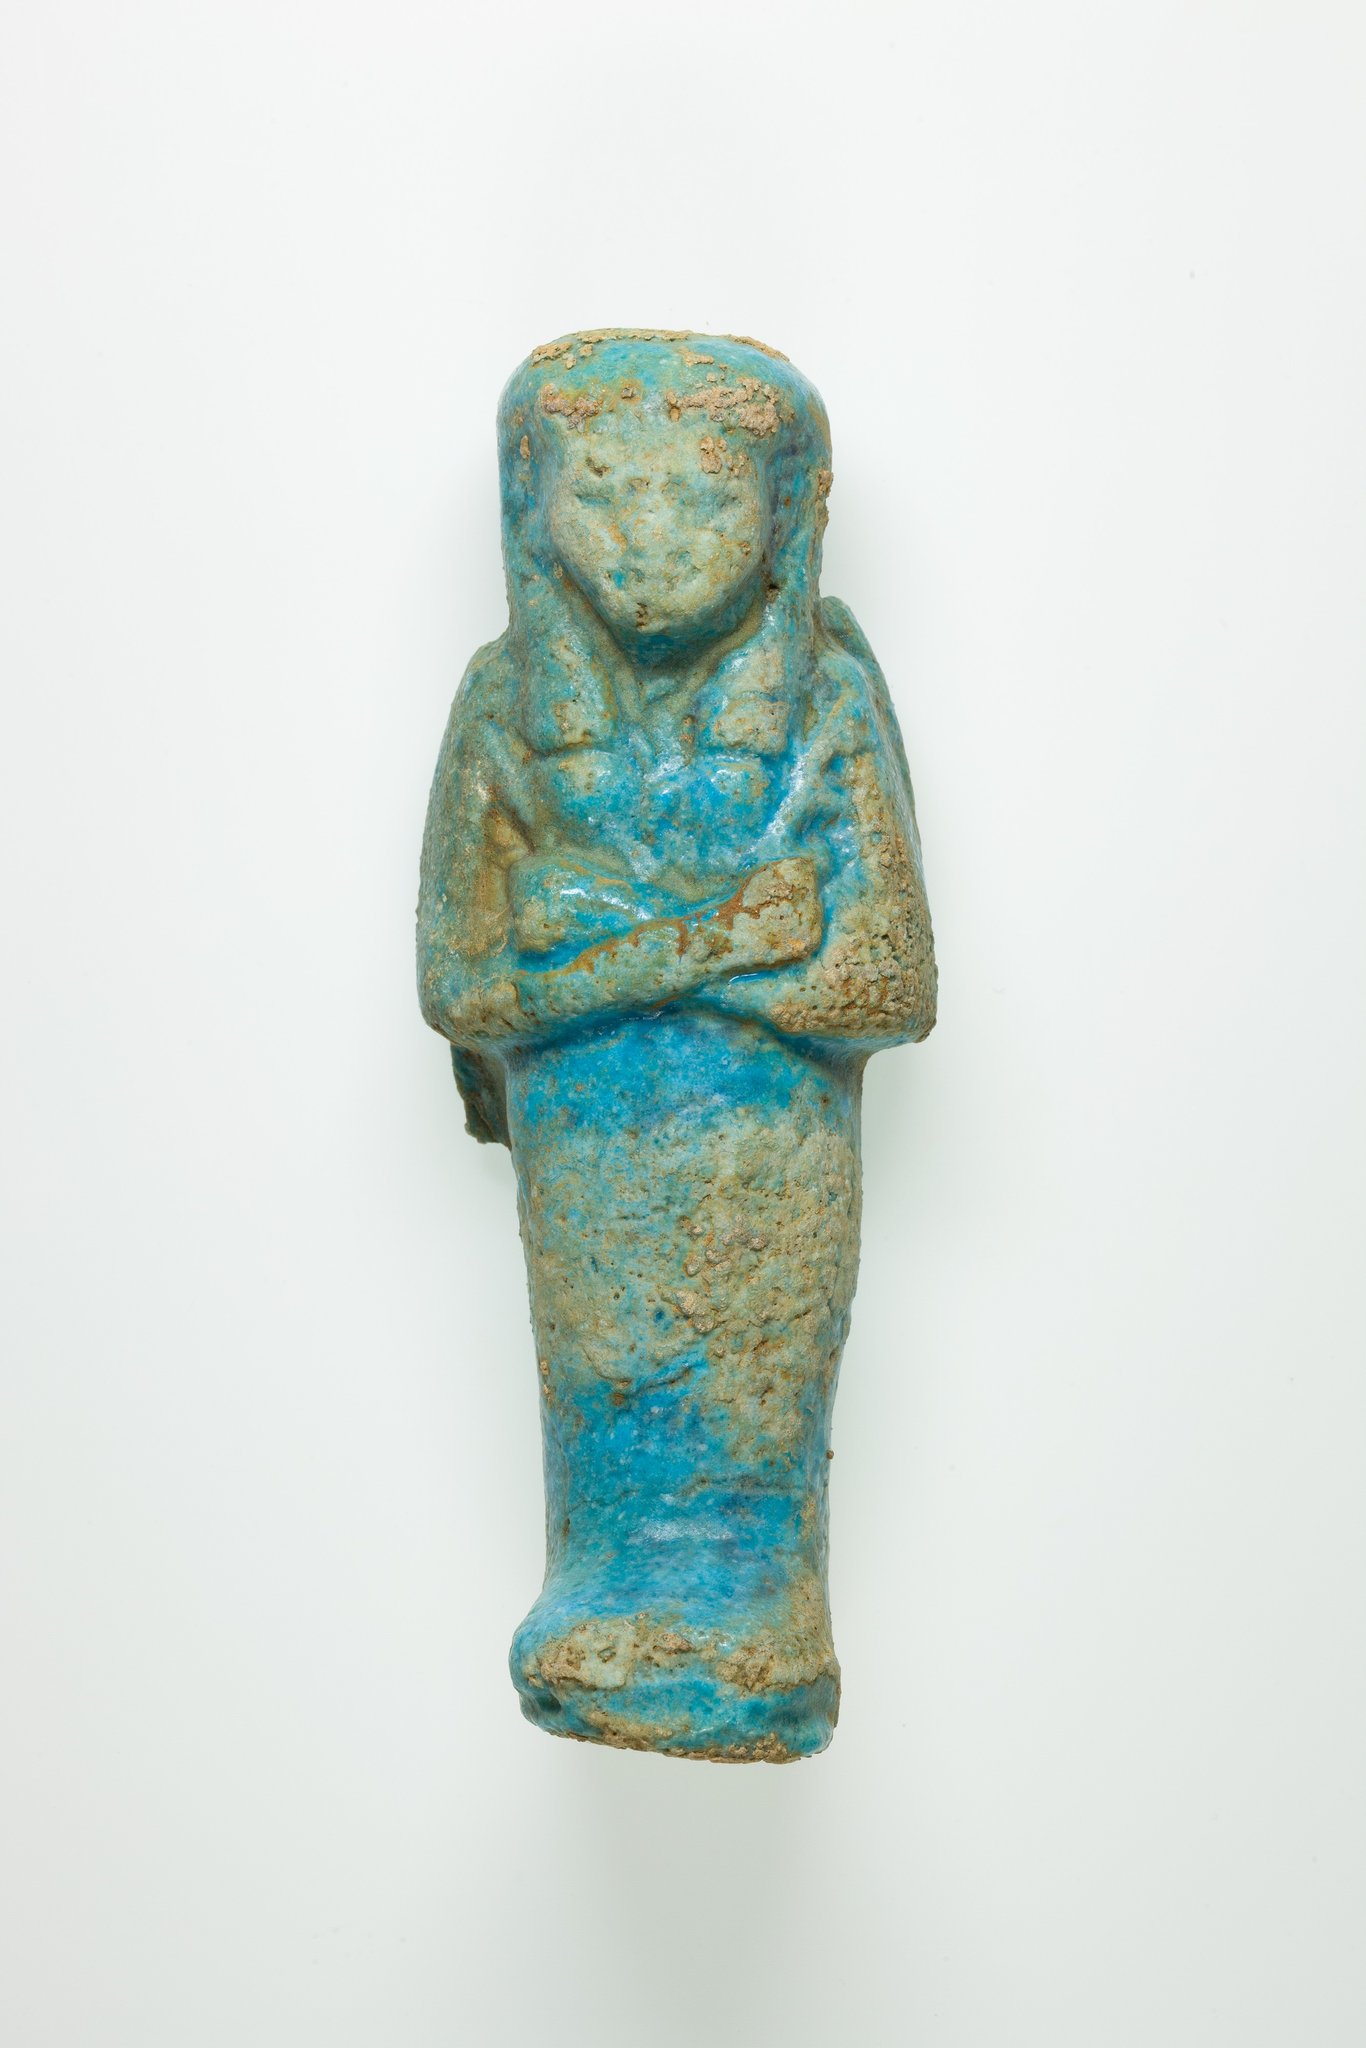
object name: worker shabti, henettawy c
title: Worker Shabti of Henettawy (C), Daughter of Isetemkheb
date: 990-970 BCE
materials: faience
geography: egypt